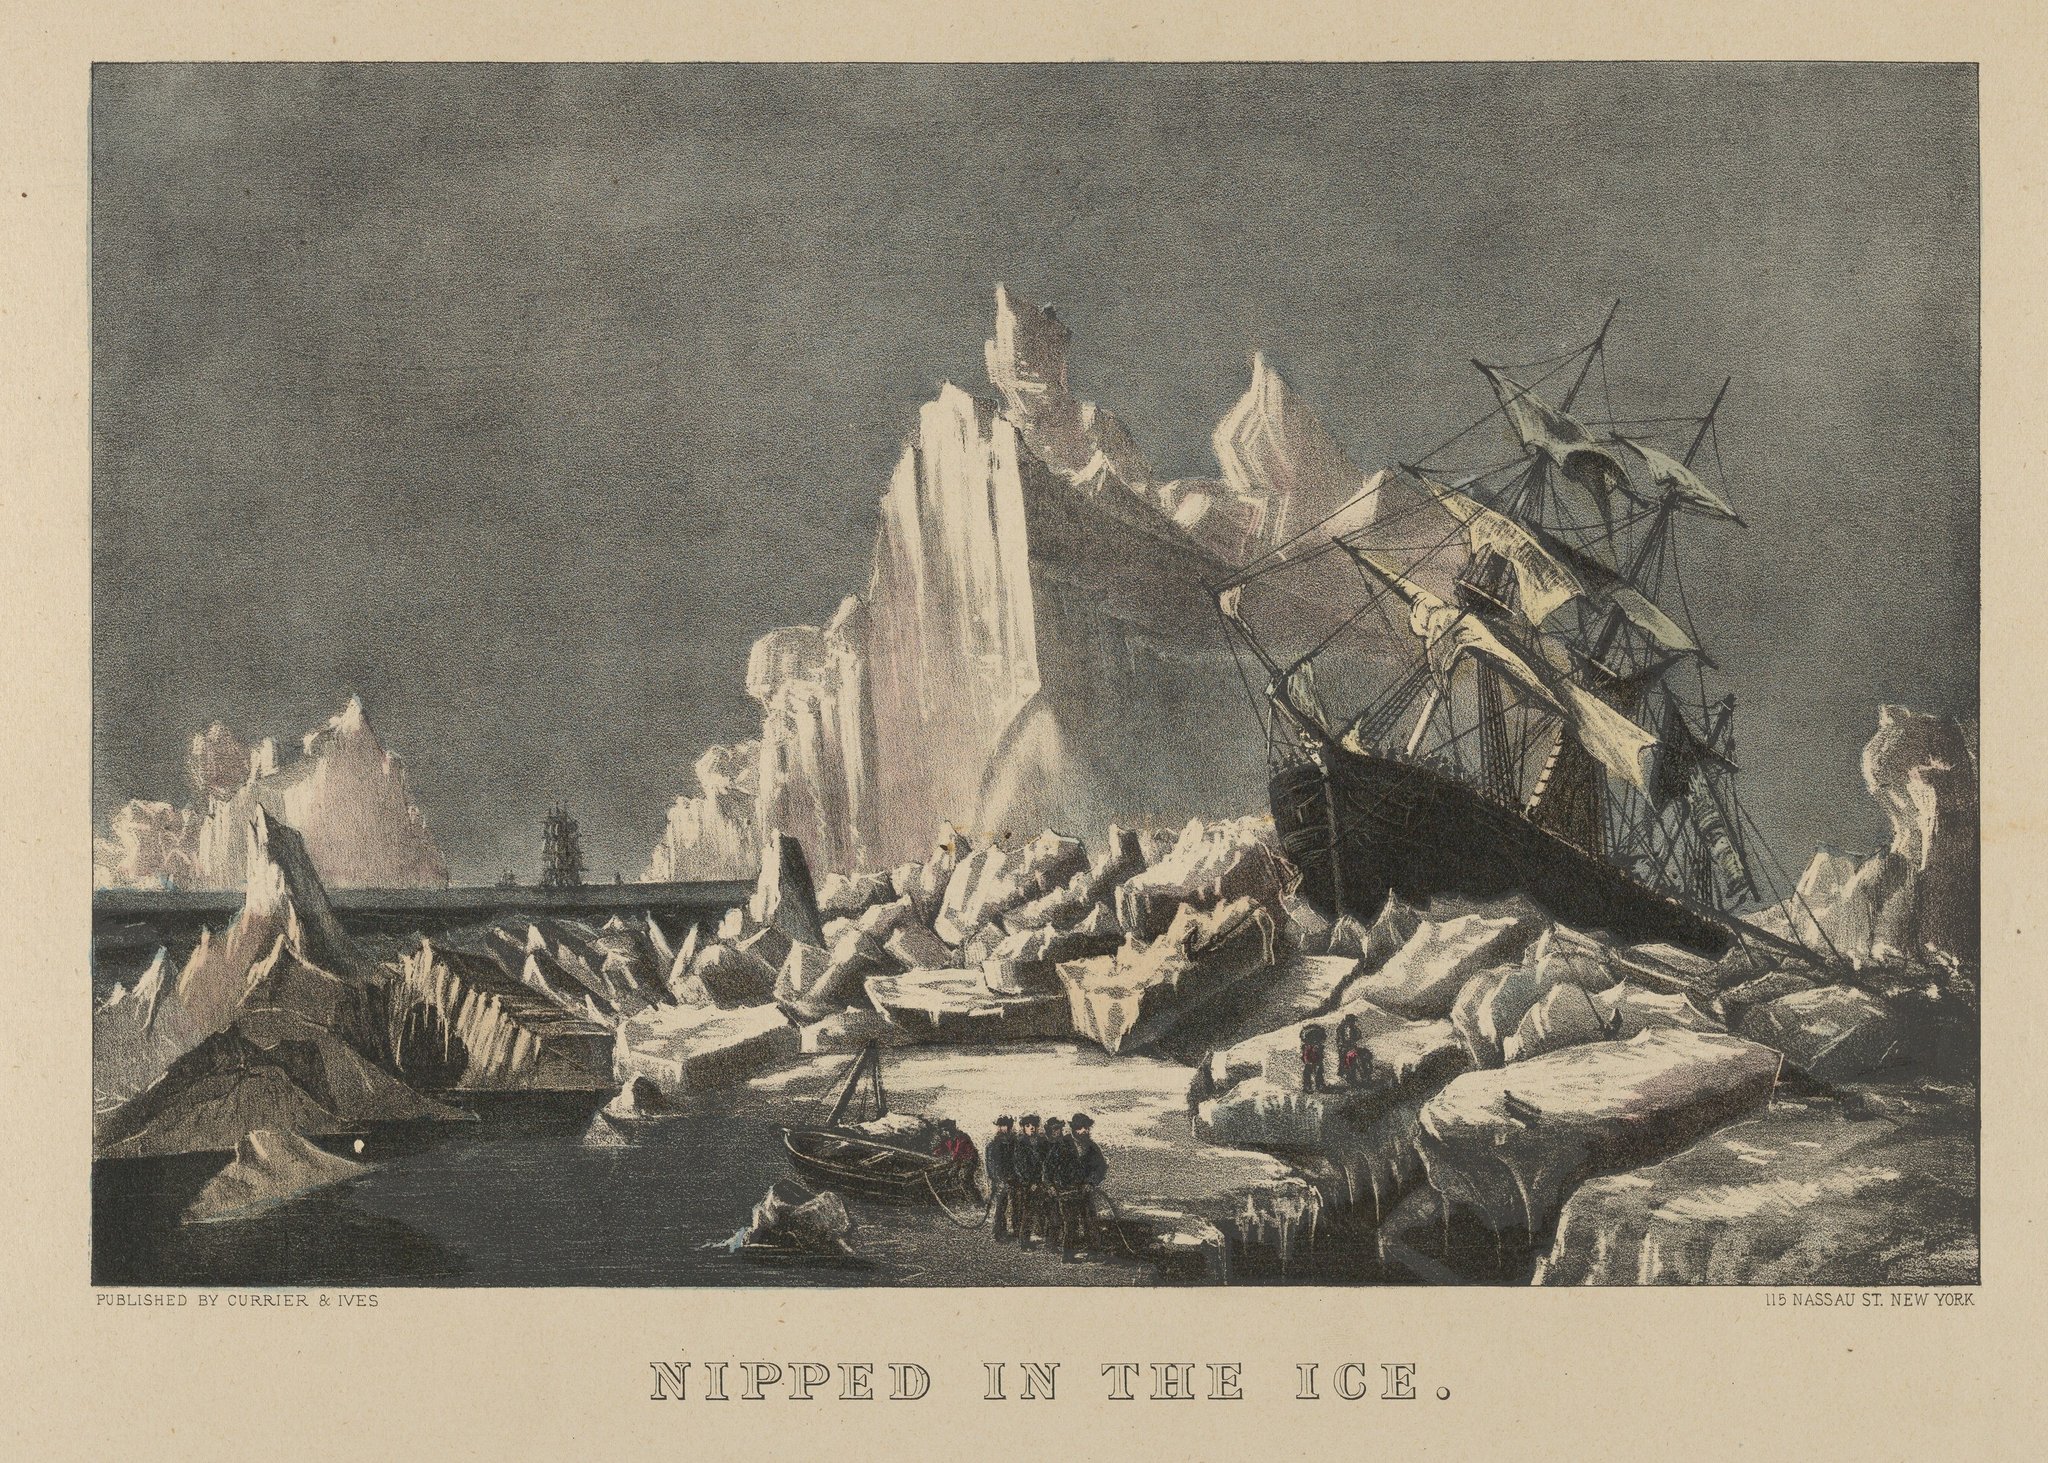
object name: print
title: Nipped in the Ice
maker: currier & ives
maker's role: lithographer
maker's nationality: american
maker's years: 1857-1907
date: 1868-1894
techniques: hand coloring, lithograph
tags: human figures,ice,boats,ships